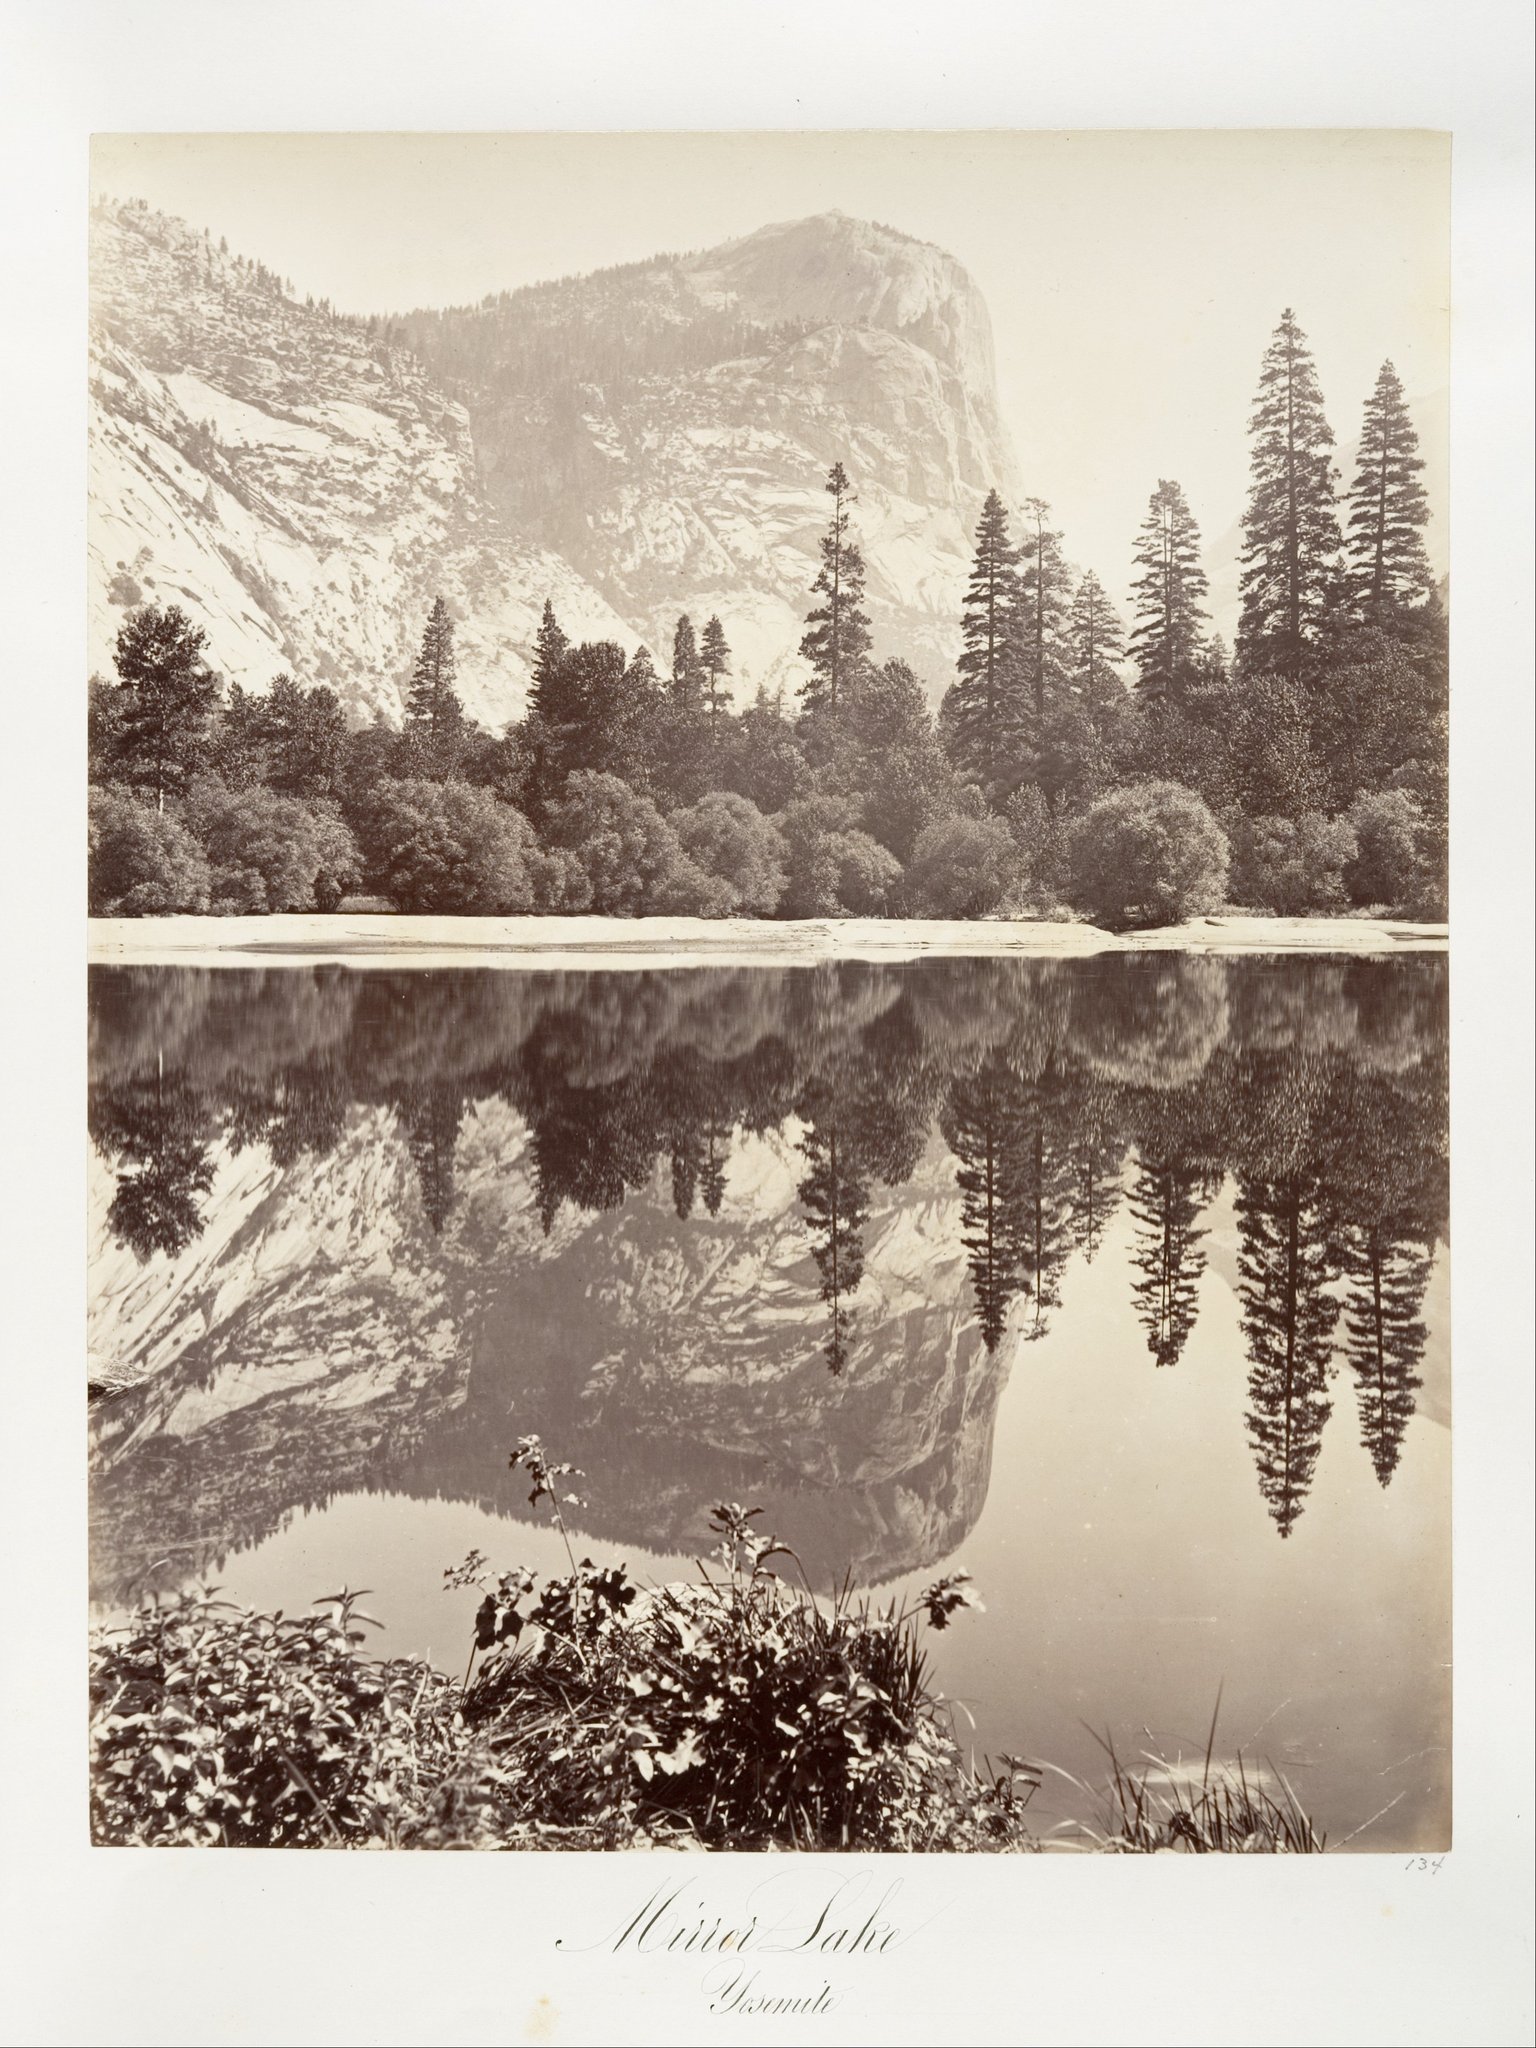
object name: photograph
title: Mirror Lake, Yosemite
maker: carleton e. watkins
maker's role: artist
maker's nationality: american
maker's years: 1829-1916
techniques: albumen silver print, glass negative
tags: lakes,mountains,landscapes